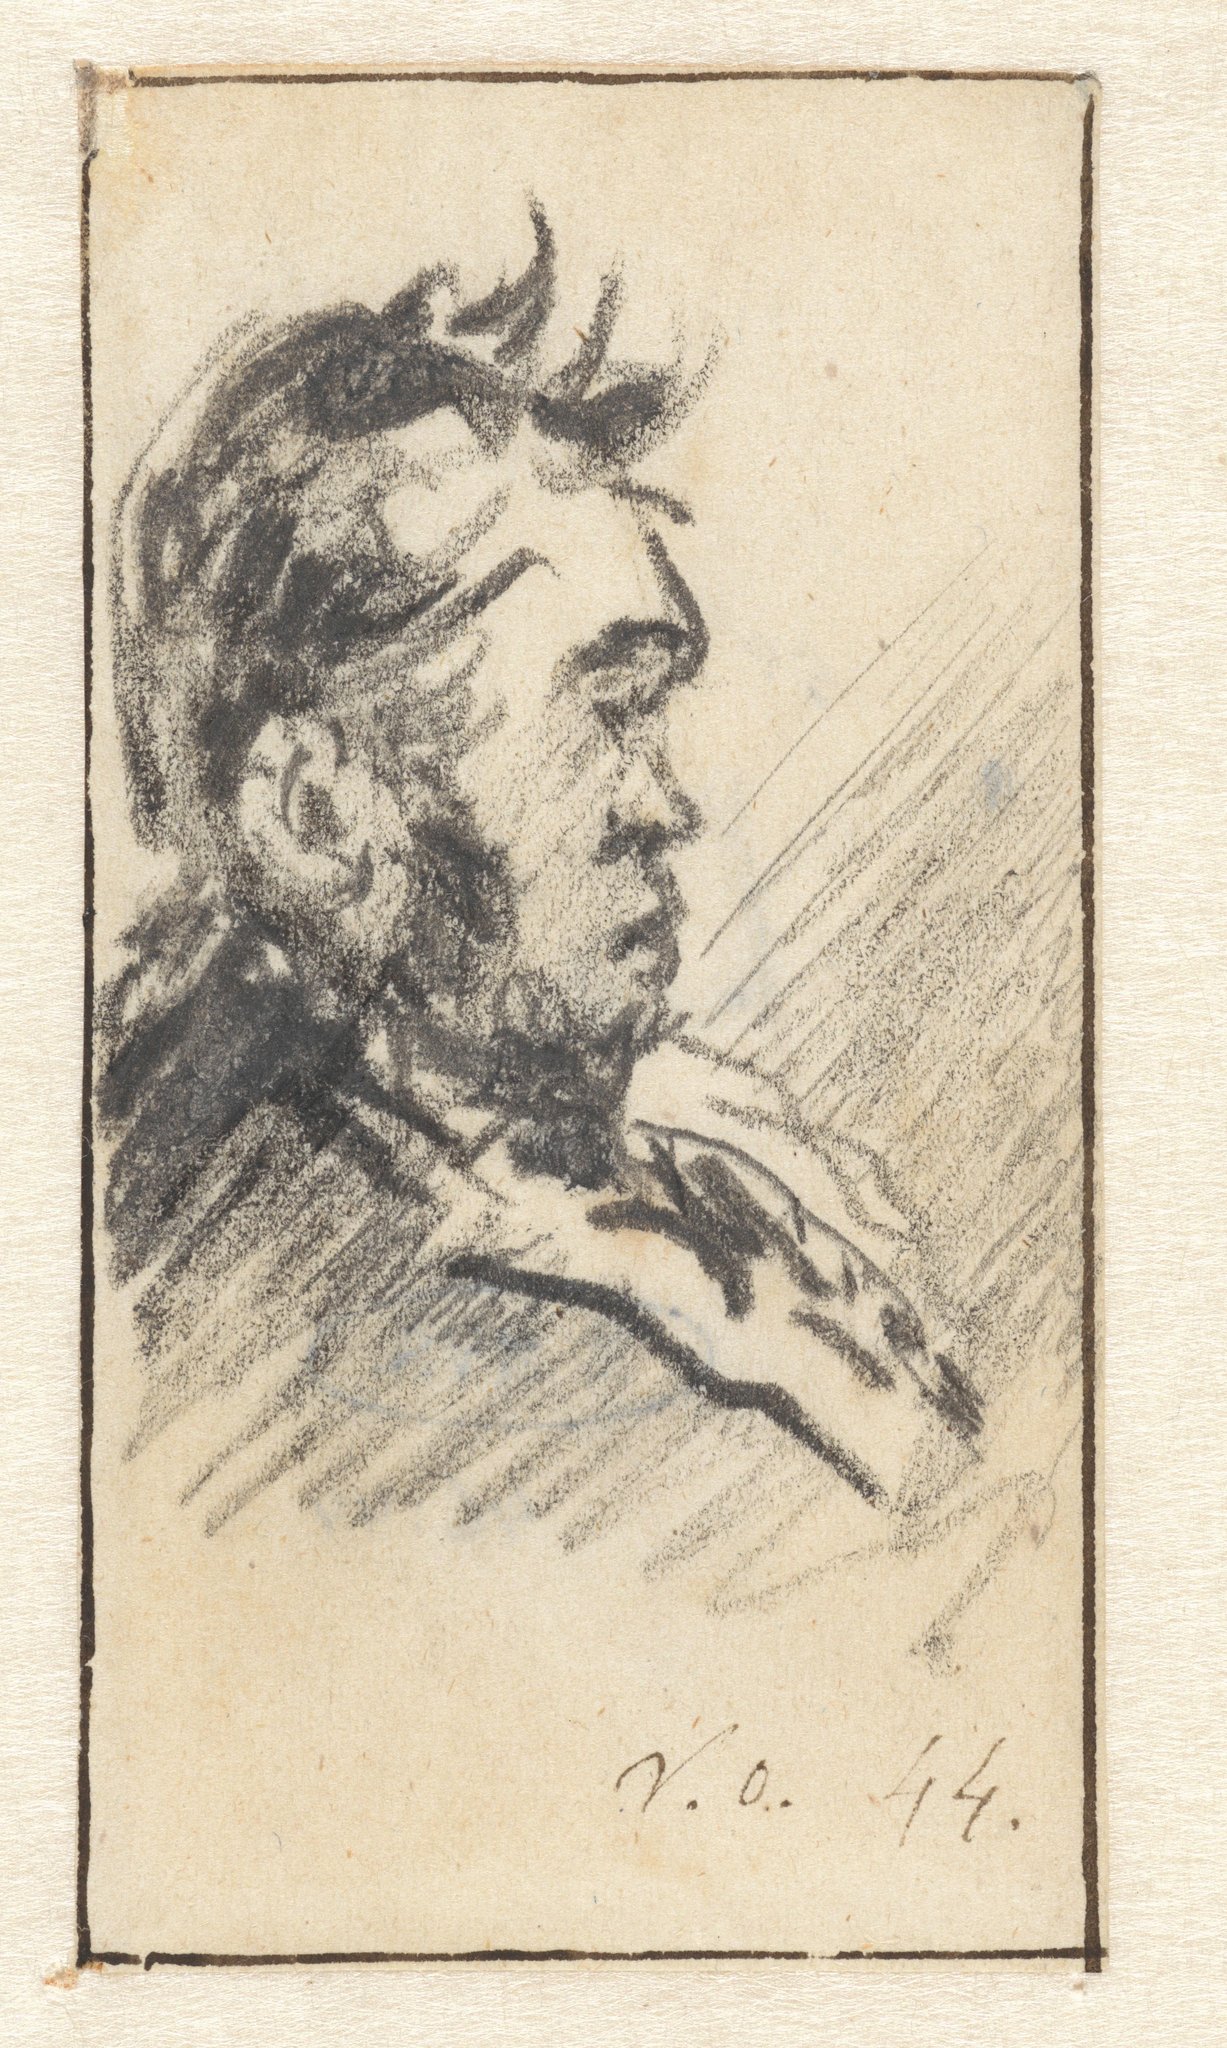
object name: drawing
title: Manskop, naar links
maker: georgius jacobus johannes van os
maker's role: draughtsman, painter, print maker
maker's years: 1782-1861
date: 1844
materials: paper, pencil